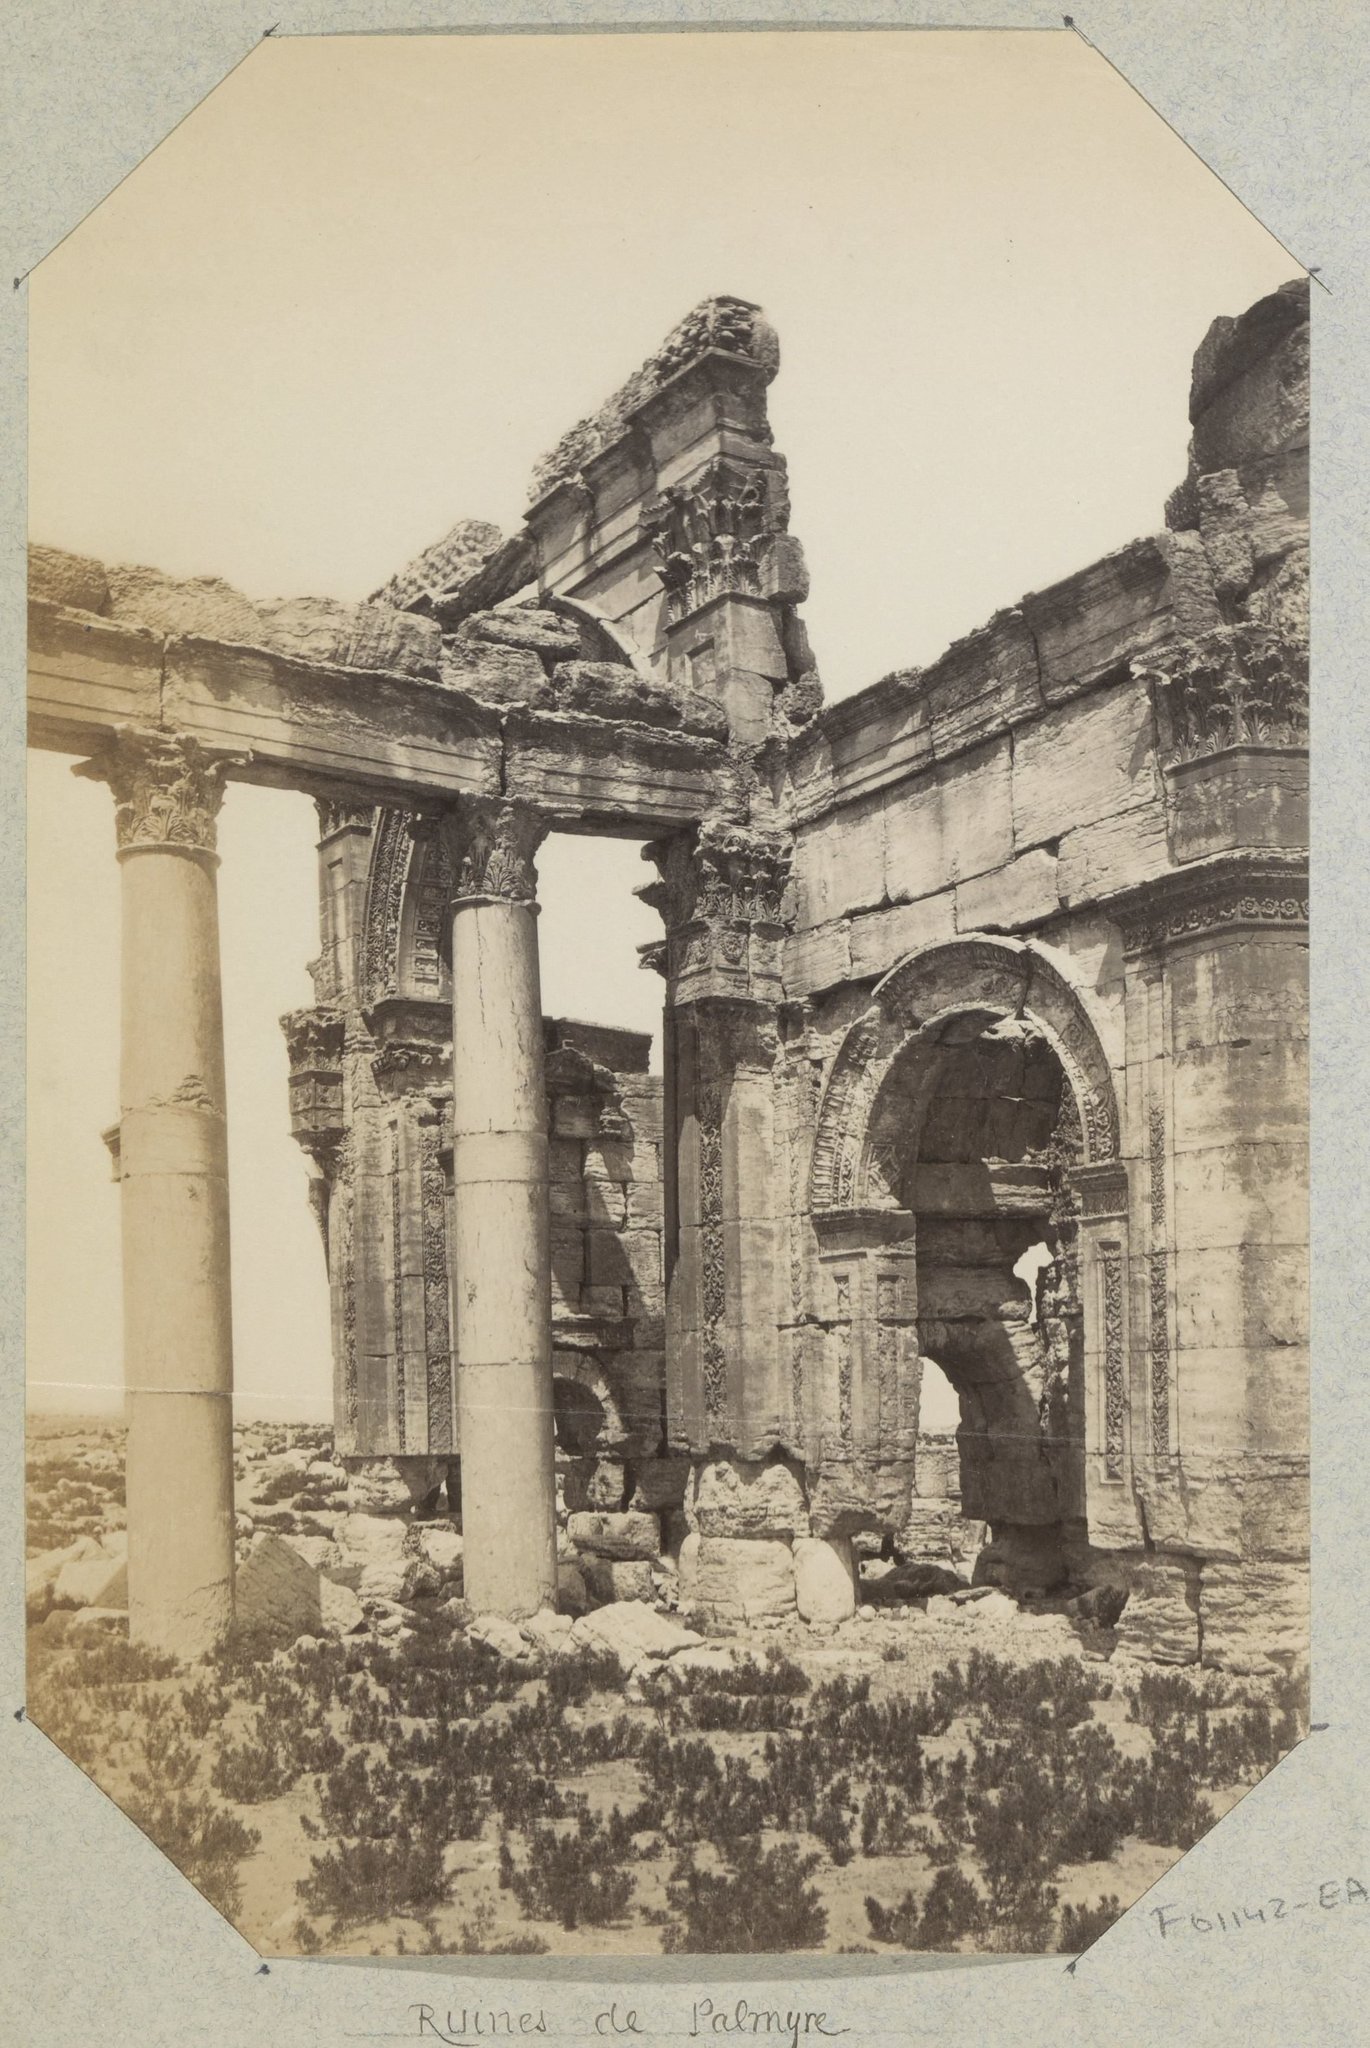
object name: photograph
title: Restanten van gebouwen met pilaren in Palmyra (Syrië)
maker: Anonymous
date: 1880-1900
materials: paper, photographic support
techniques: albumen print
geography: palmyra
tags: column, pillar ~ architecture, ruin of a building ~ architecture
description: Onderdeel van Album van een Franse amateur met foto's van Frankrijk, Algerije, Palmyra, de Wereldtentoonstelling van 1900 en van bekende Fransen.